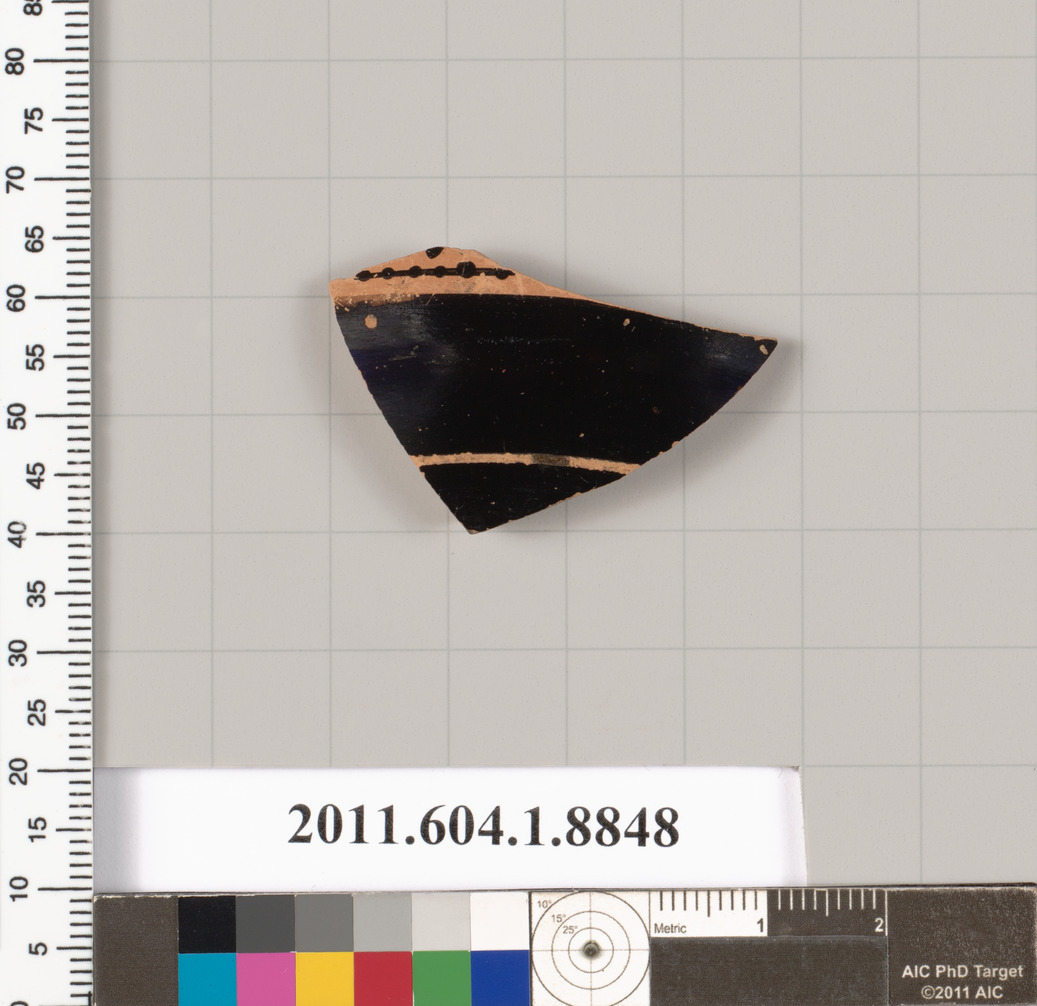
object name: kylix fragment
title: Terracotta fragment of a stemless kylix (drinking cup)?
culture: greek, attic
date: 500-470 BCE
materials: terracotta